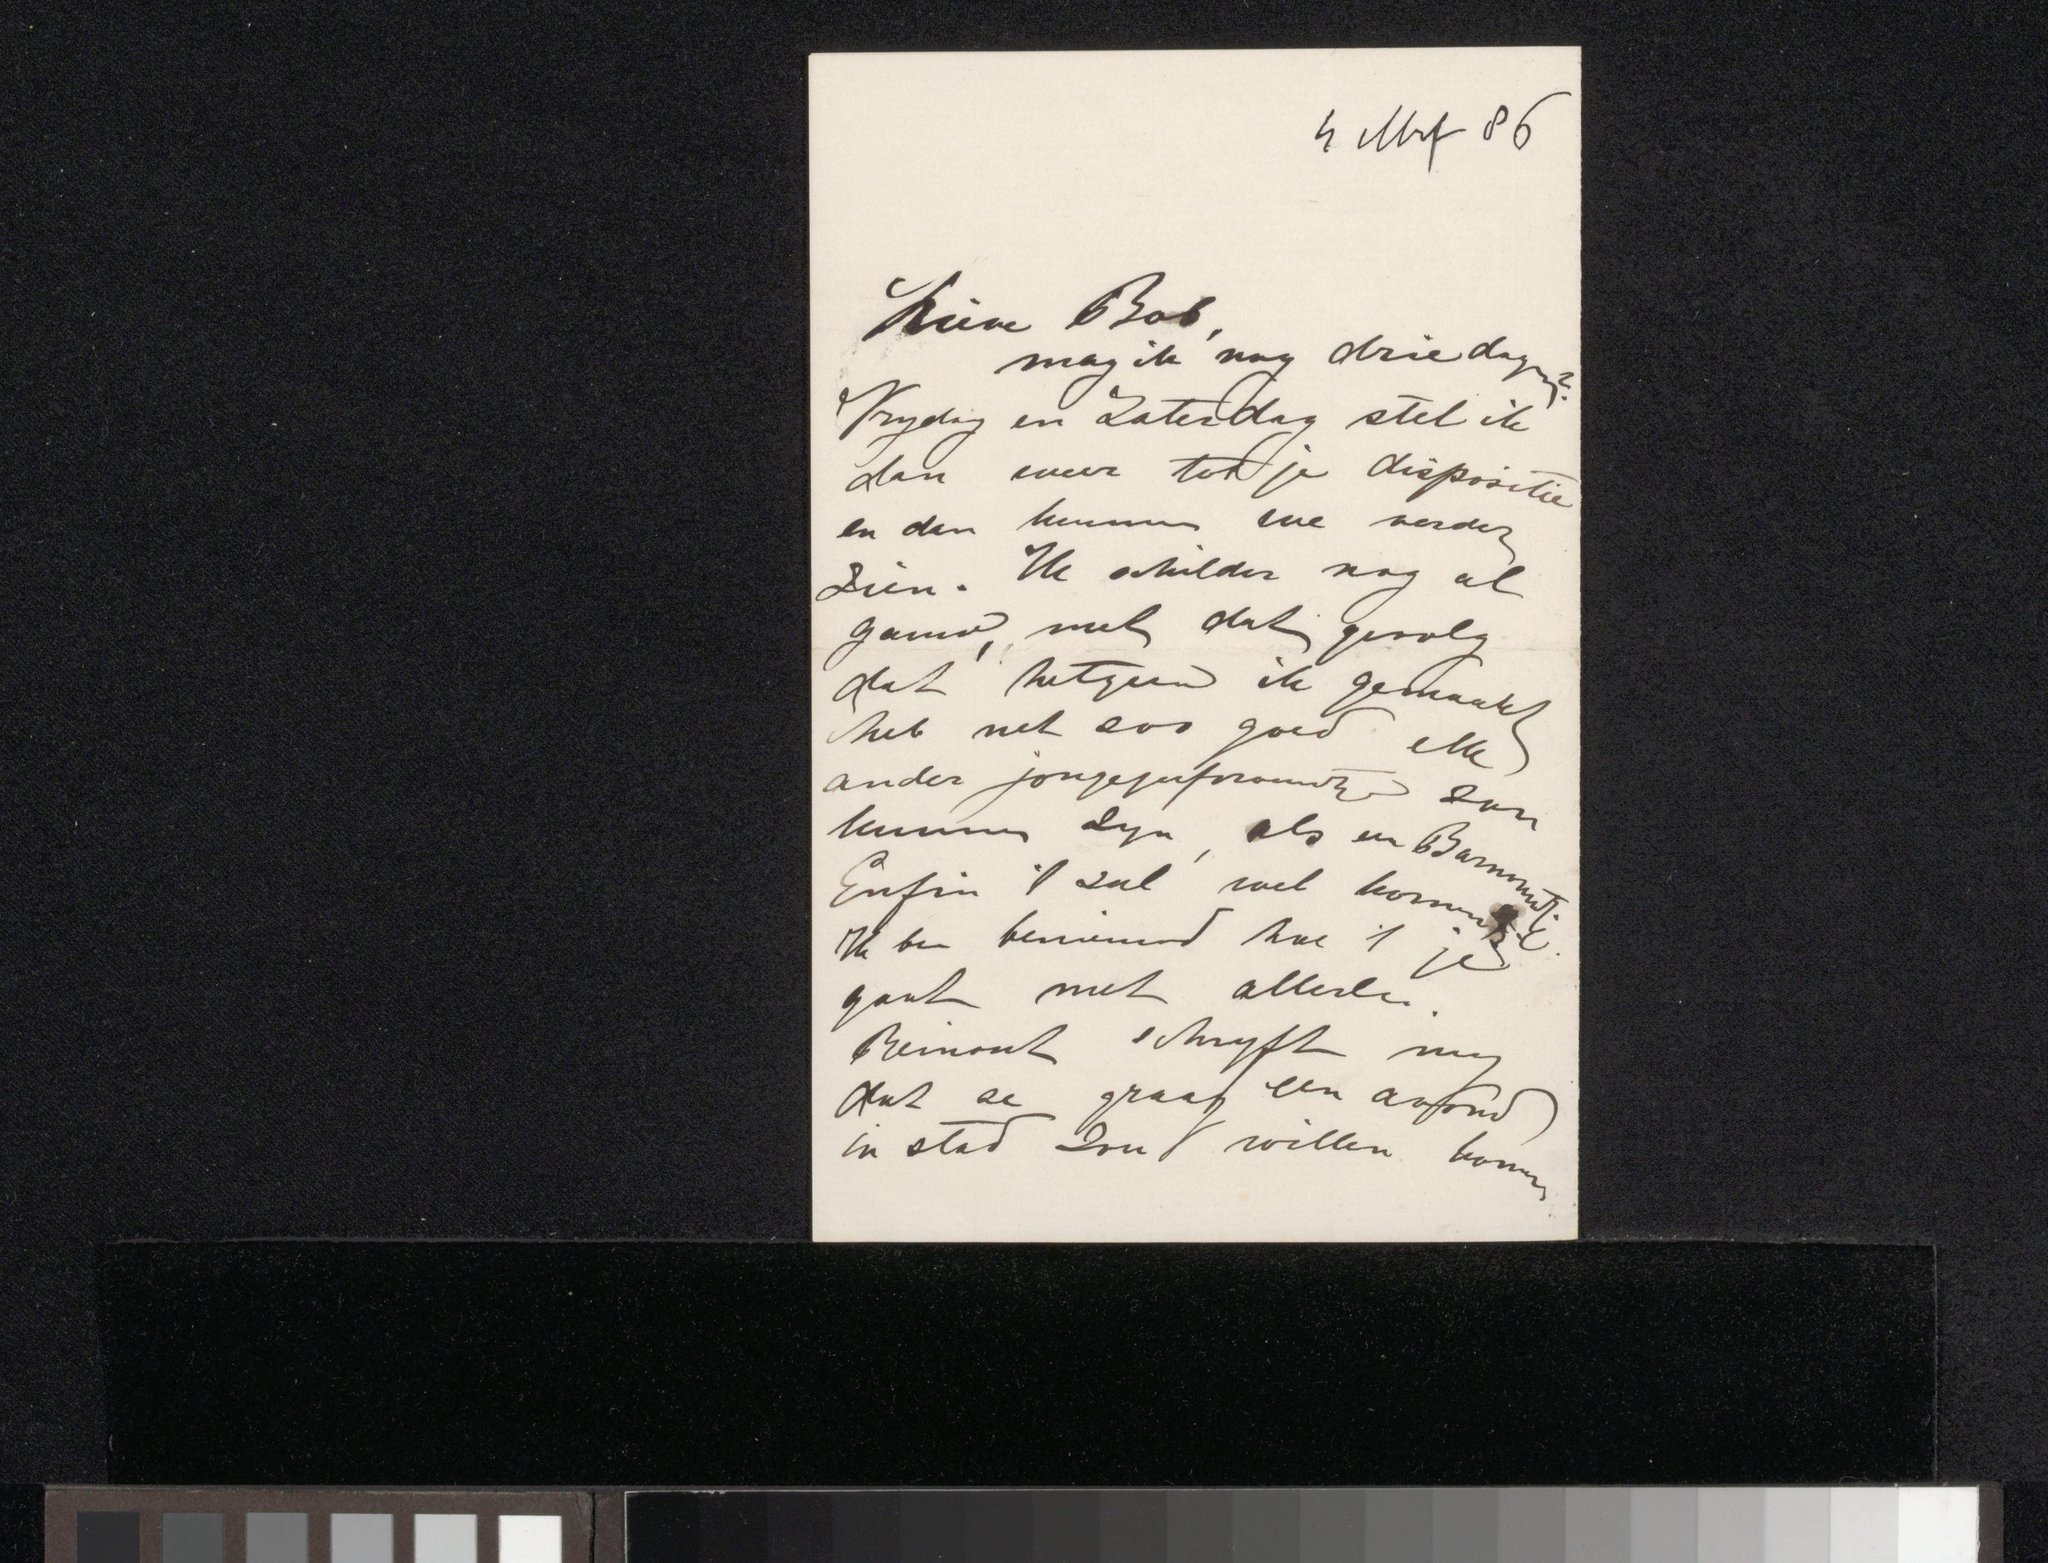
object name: letter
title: Brief aan Jan Veth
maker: wally moes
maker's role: draughtsman, print maker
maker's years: 1856-1918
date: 1886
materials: ink, paper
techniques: pen, writing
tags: painter, designer, jan veth, painting (including book-illumination, miniature-painting), historical persons (portraits and scenes from the life)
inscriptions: watermark, collector's mark: ‘RPK’